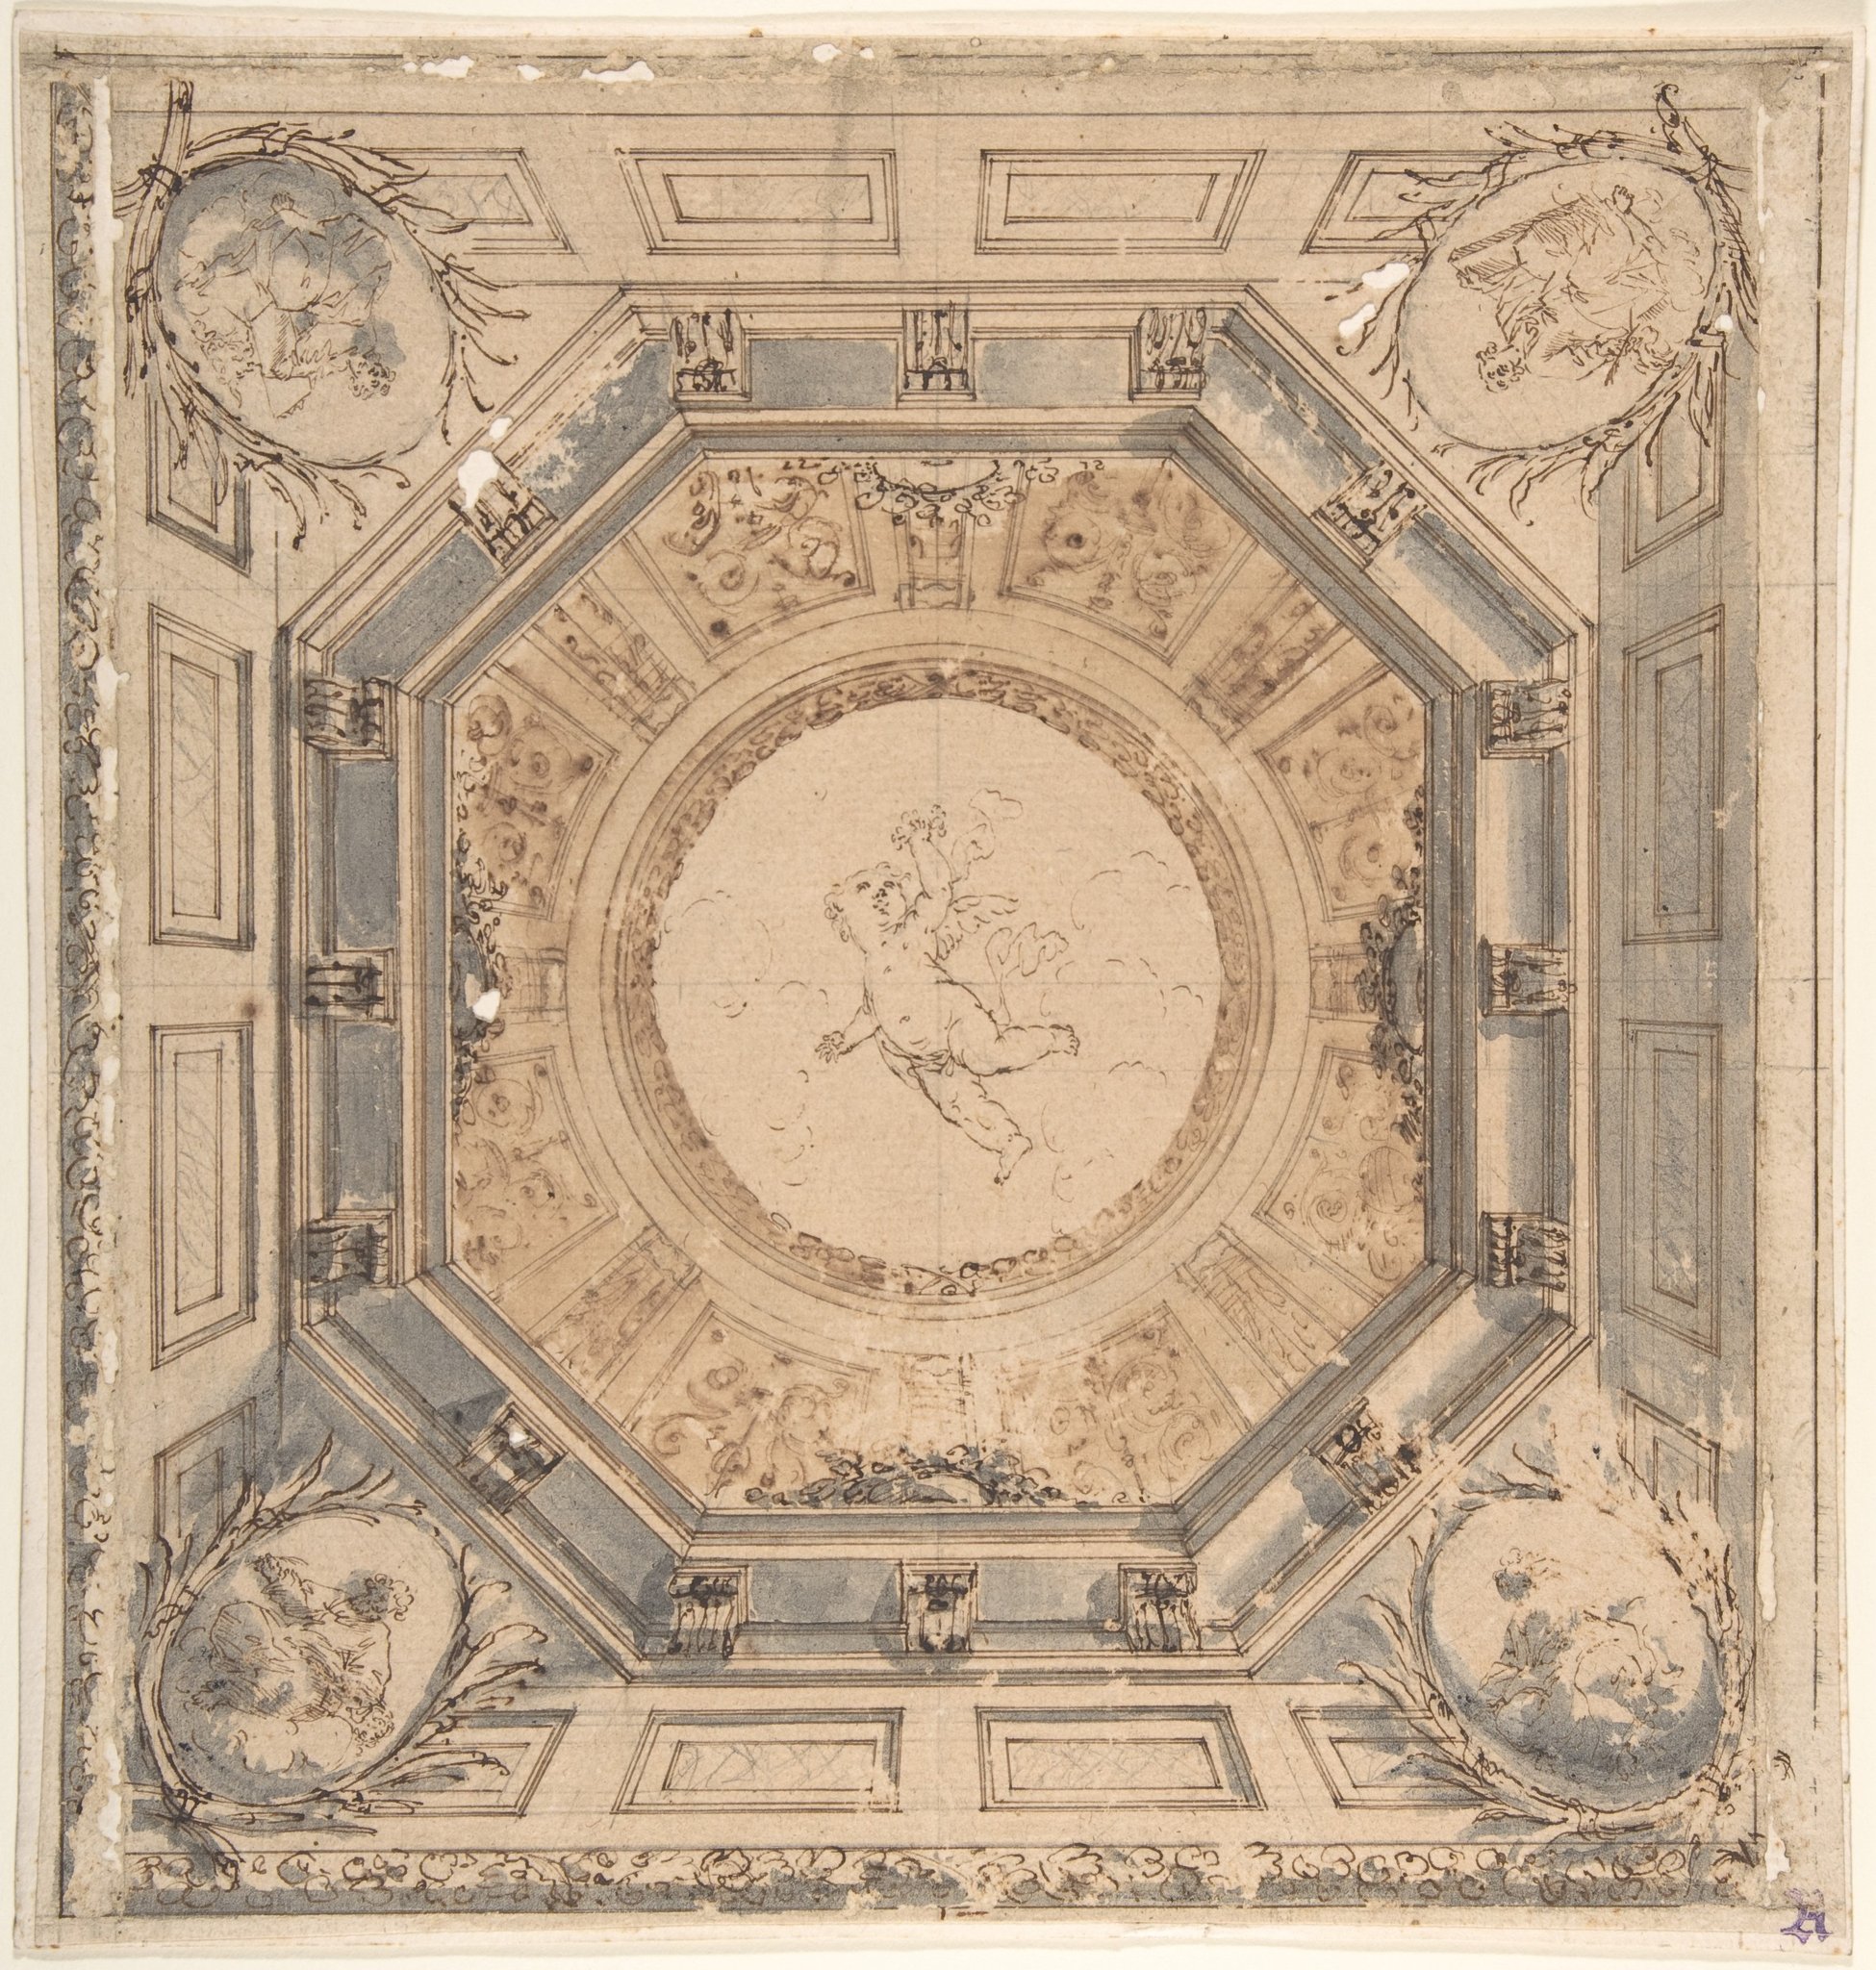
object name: drawing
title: Design for a Square Trompe L'Oeil Ceiling with the Four Evangelists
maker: anonymous, italian, 18th century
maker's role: artist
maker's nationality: italian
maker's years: 1700-1800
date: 1701-1800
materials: chalk, ink, paper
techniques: brush, pen, wash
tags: ceilings